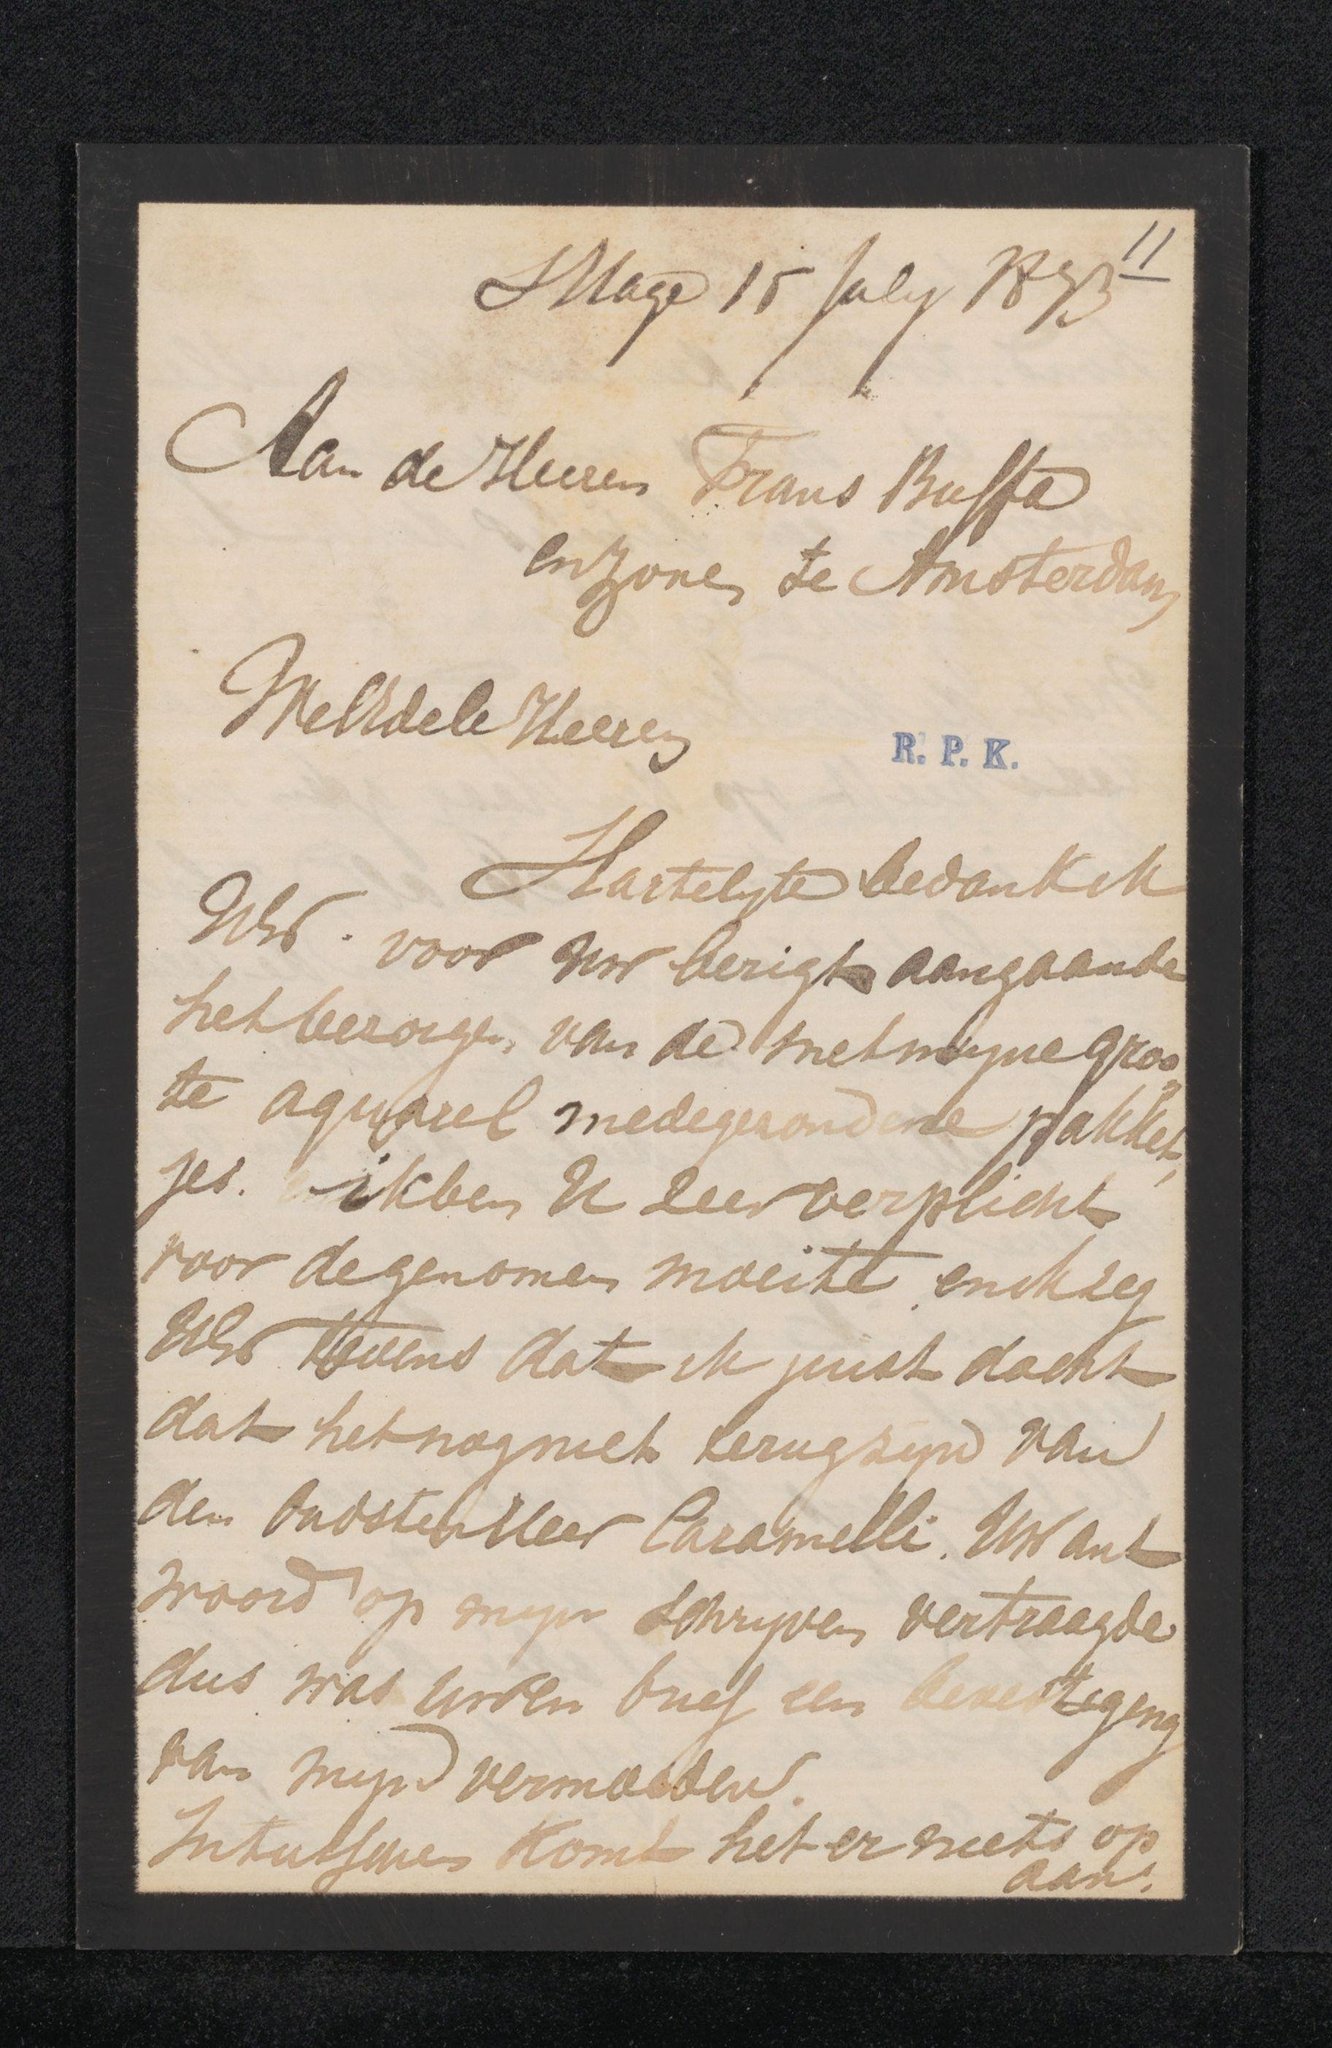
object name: letter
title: Brief aan Frans Buffa en Zonen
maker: pieter stortenbeker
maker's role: draughtsman, painter, print maker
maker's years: 1828-1898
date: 1873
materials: ink, paper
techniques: pen, writing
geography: the hague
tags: publisher, art trade, art shop, drawing, money, the hague, amsterdam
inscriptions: collector's mark: Lugt 2233